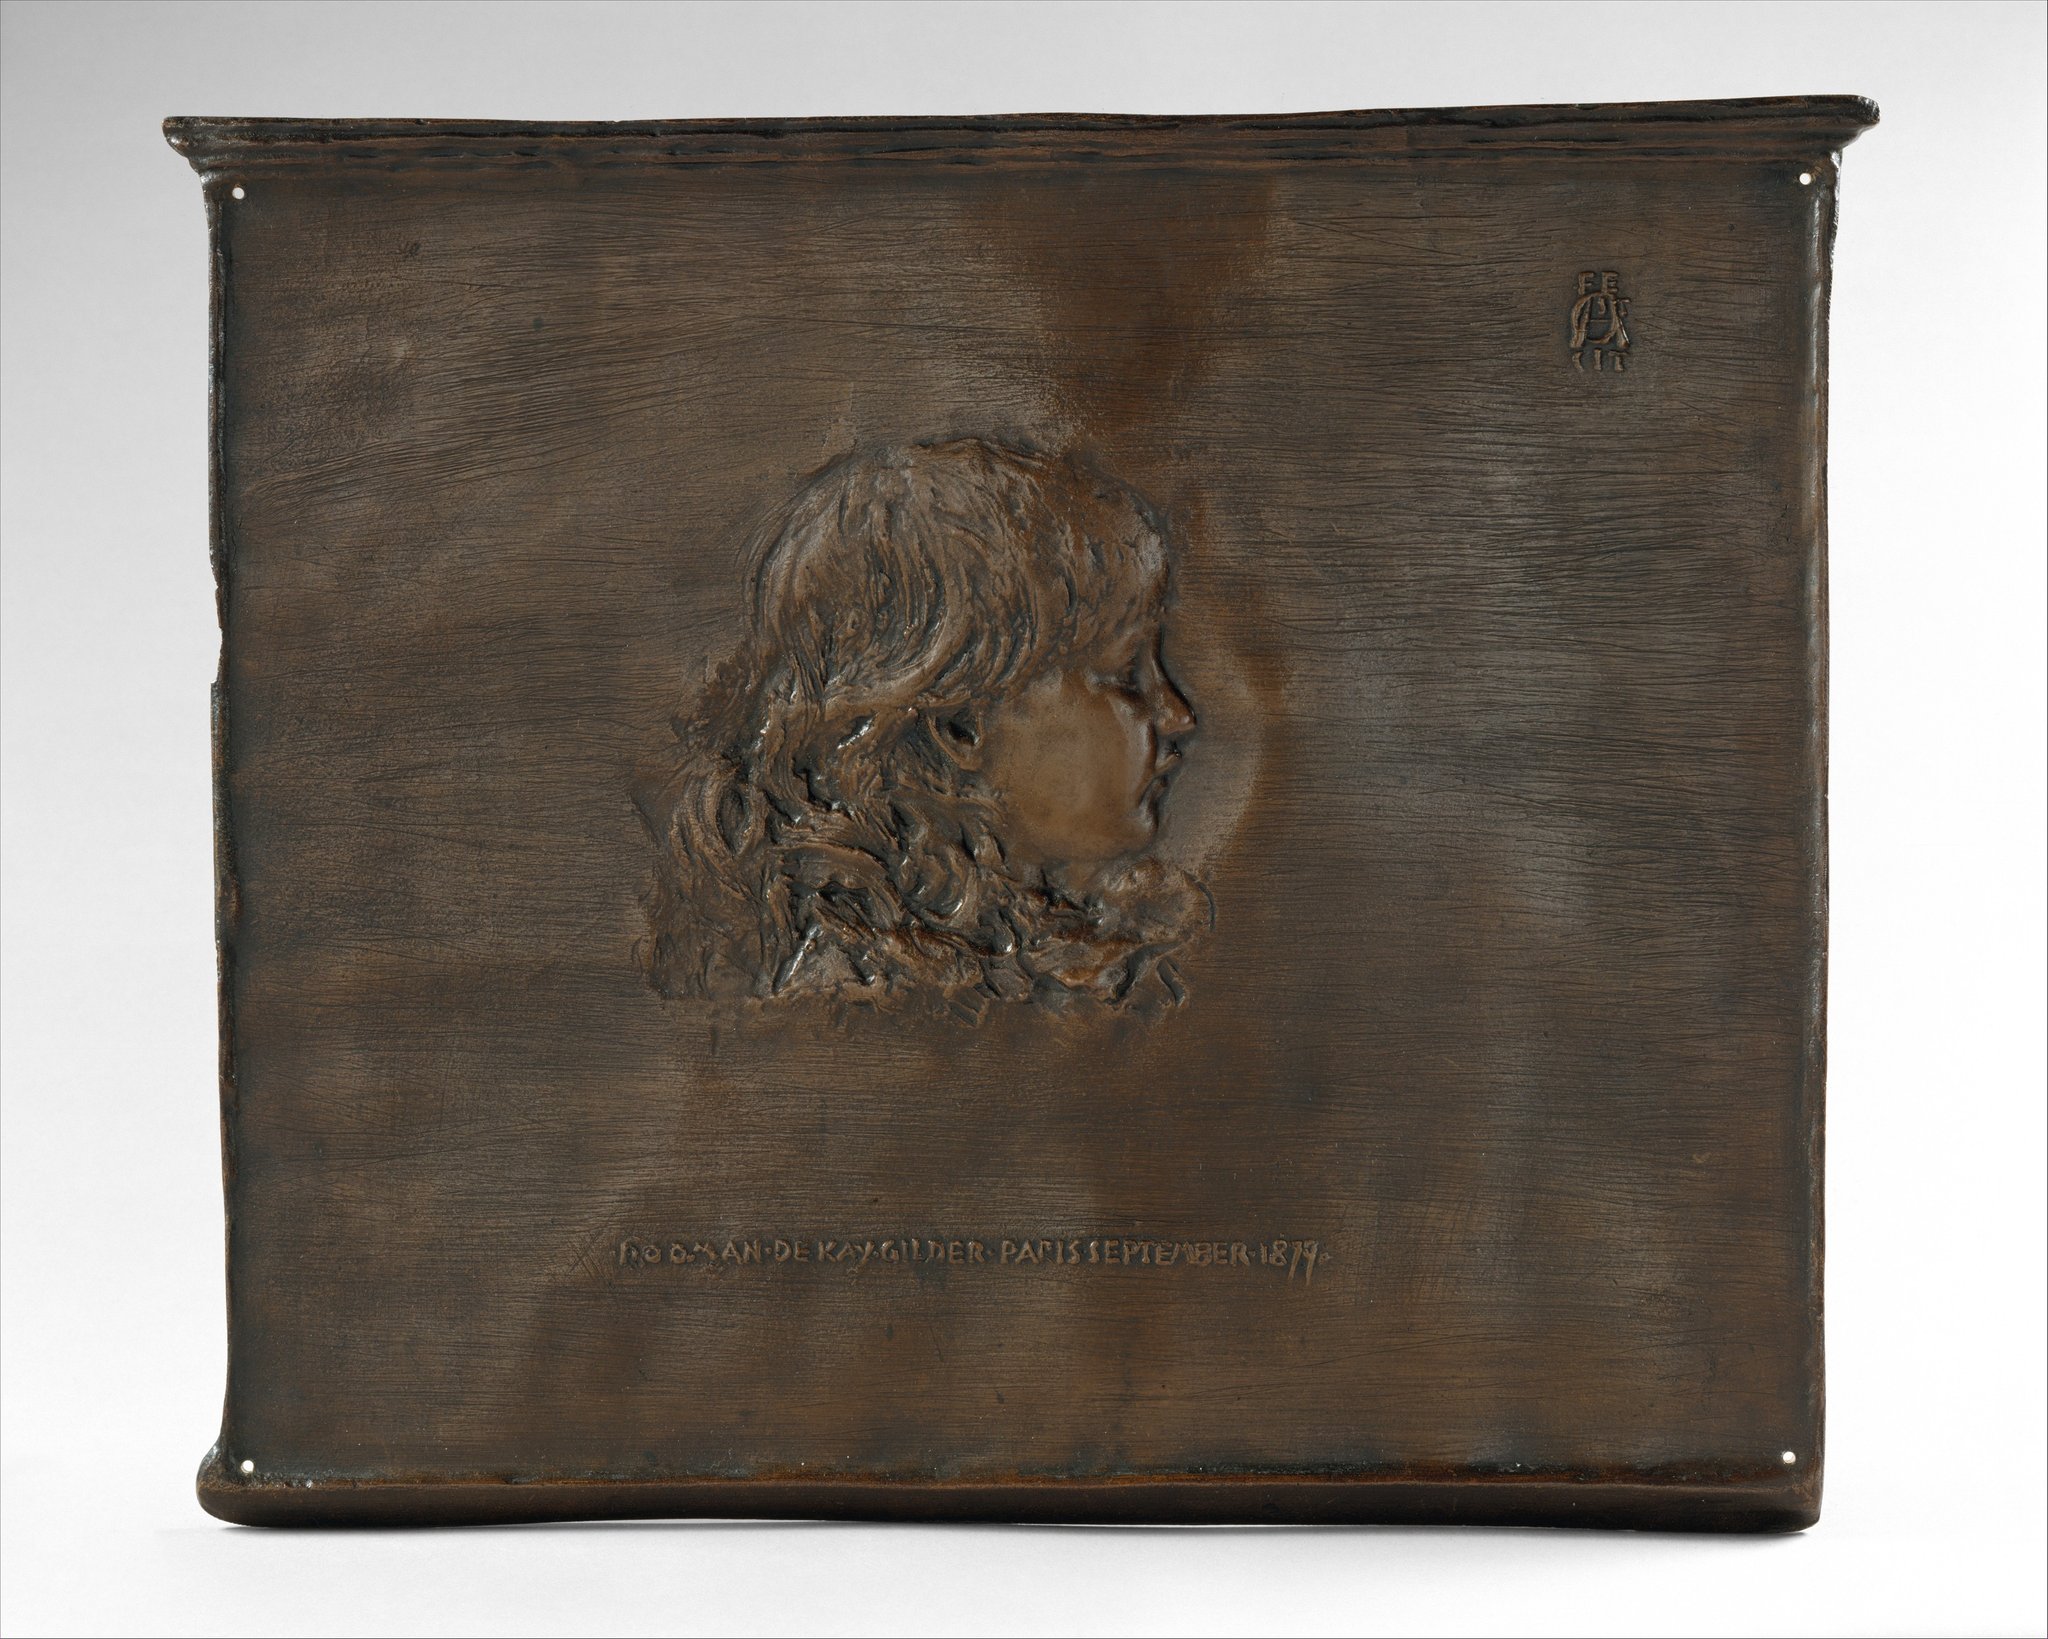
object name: sculpture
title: Rodman de Kay Gilder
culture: american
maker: augustus saint-gaudens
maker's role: artist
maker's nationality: american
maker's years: 1848-1907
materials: bronze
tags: girls,profiles